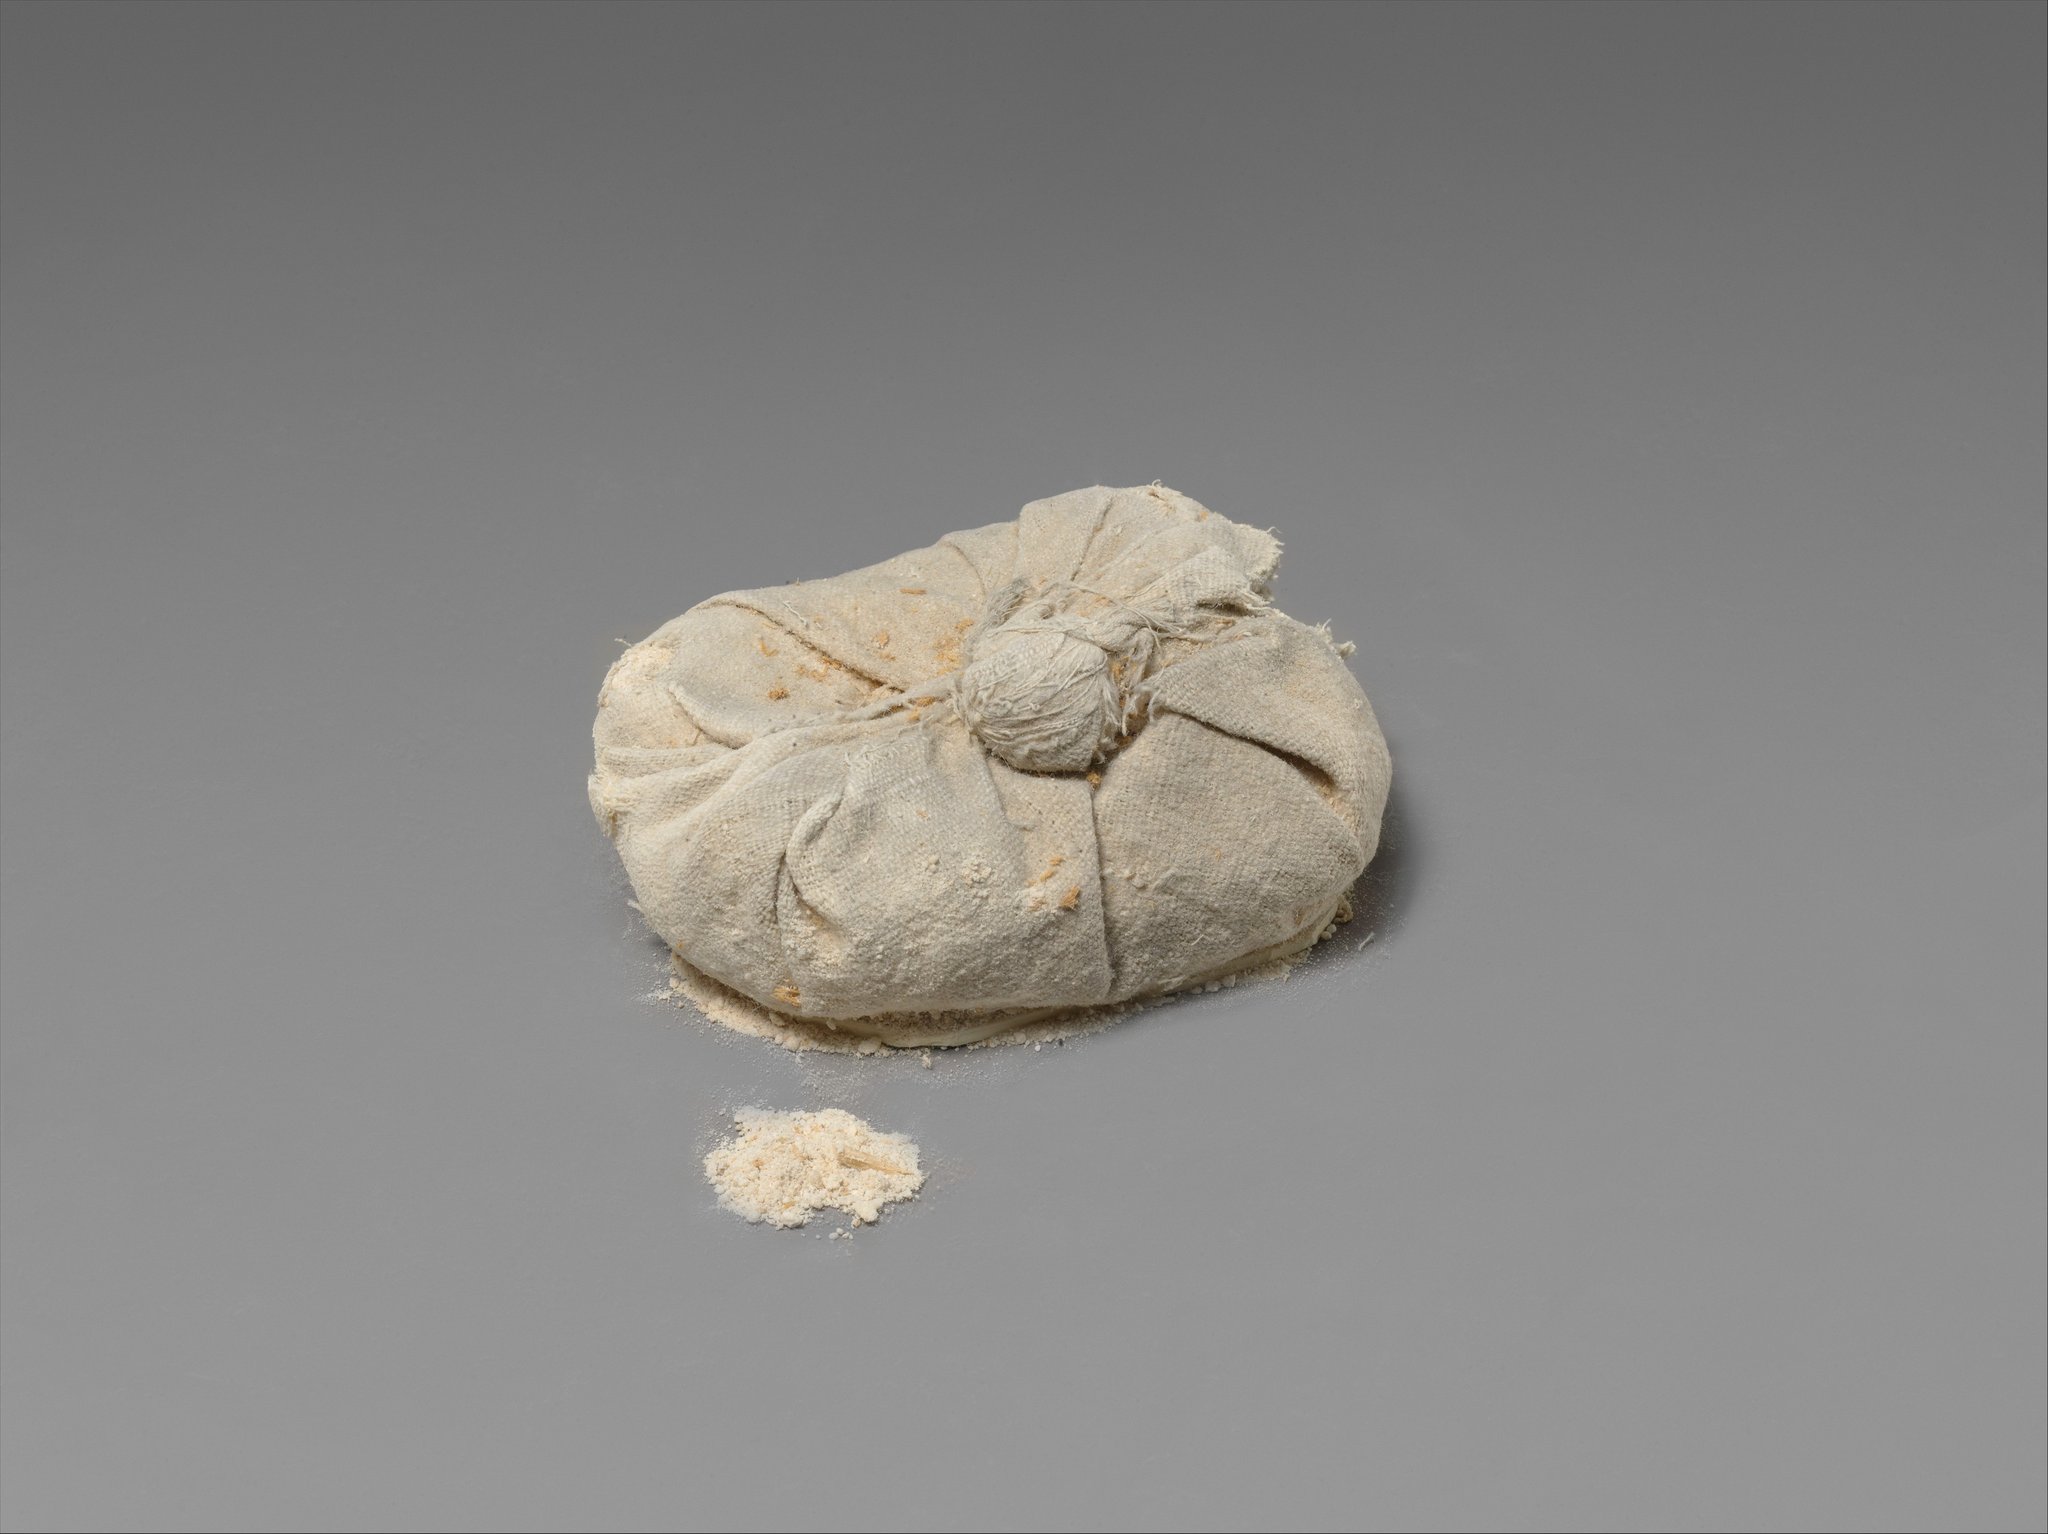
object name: natron bag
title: Bag of Natron from Tutankhamun's Embalming Cache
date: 1336-1327 BCE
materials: linen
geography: egypt